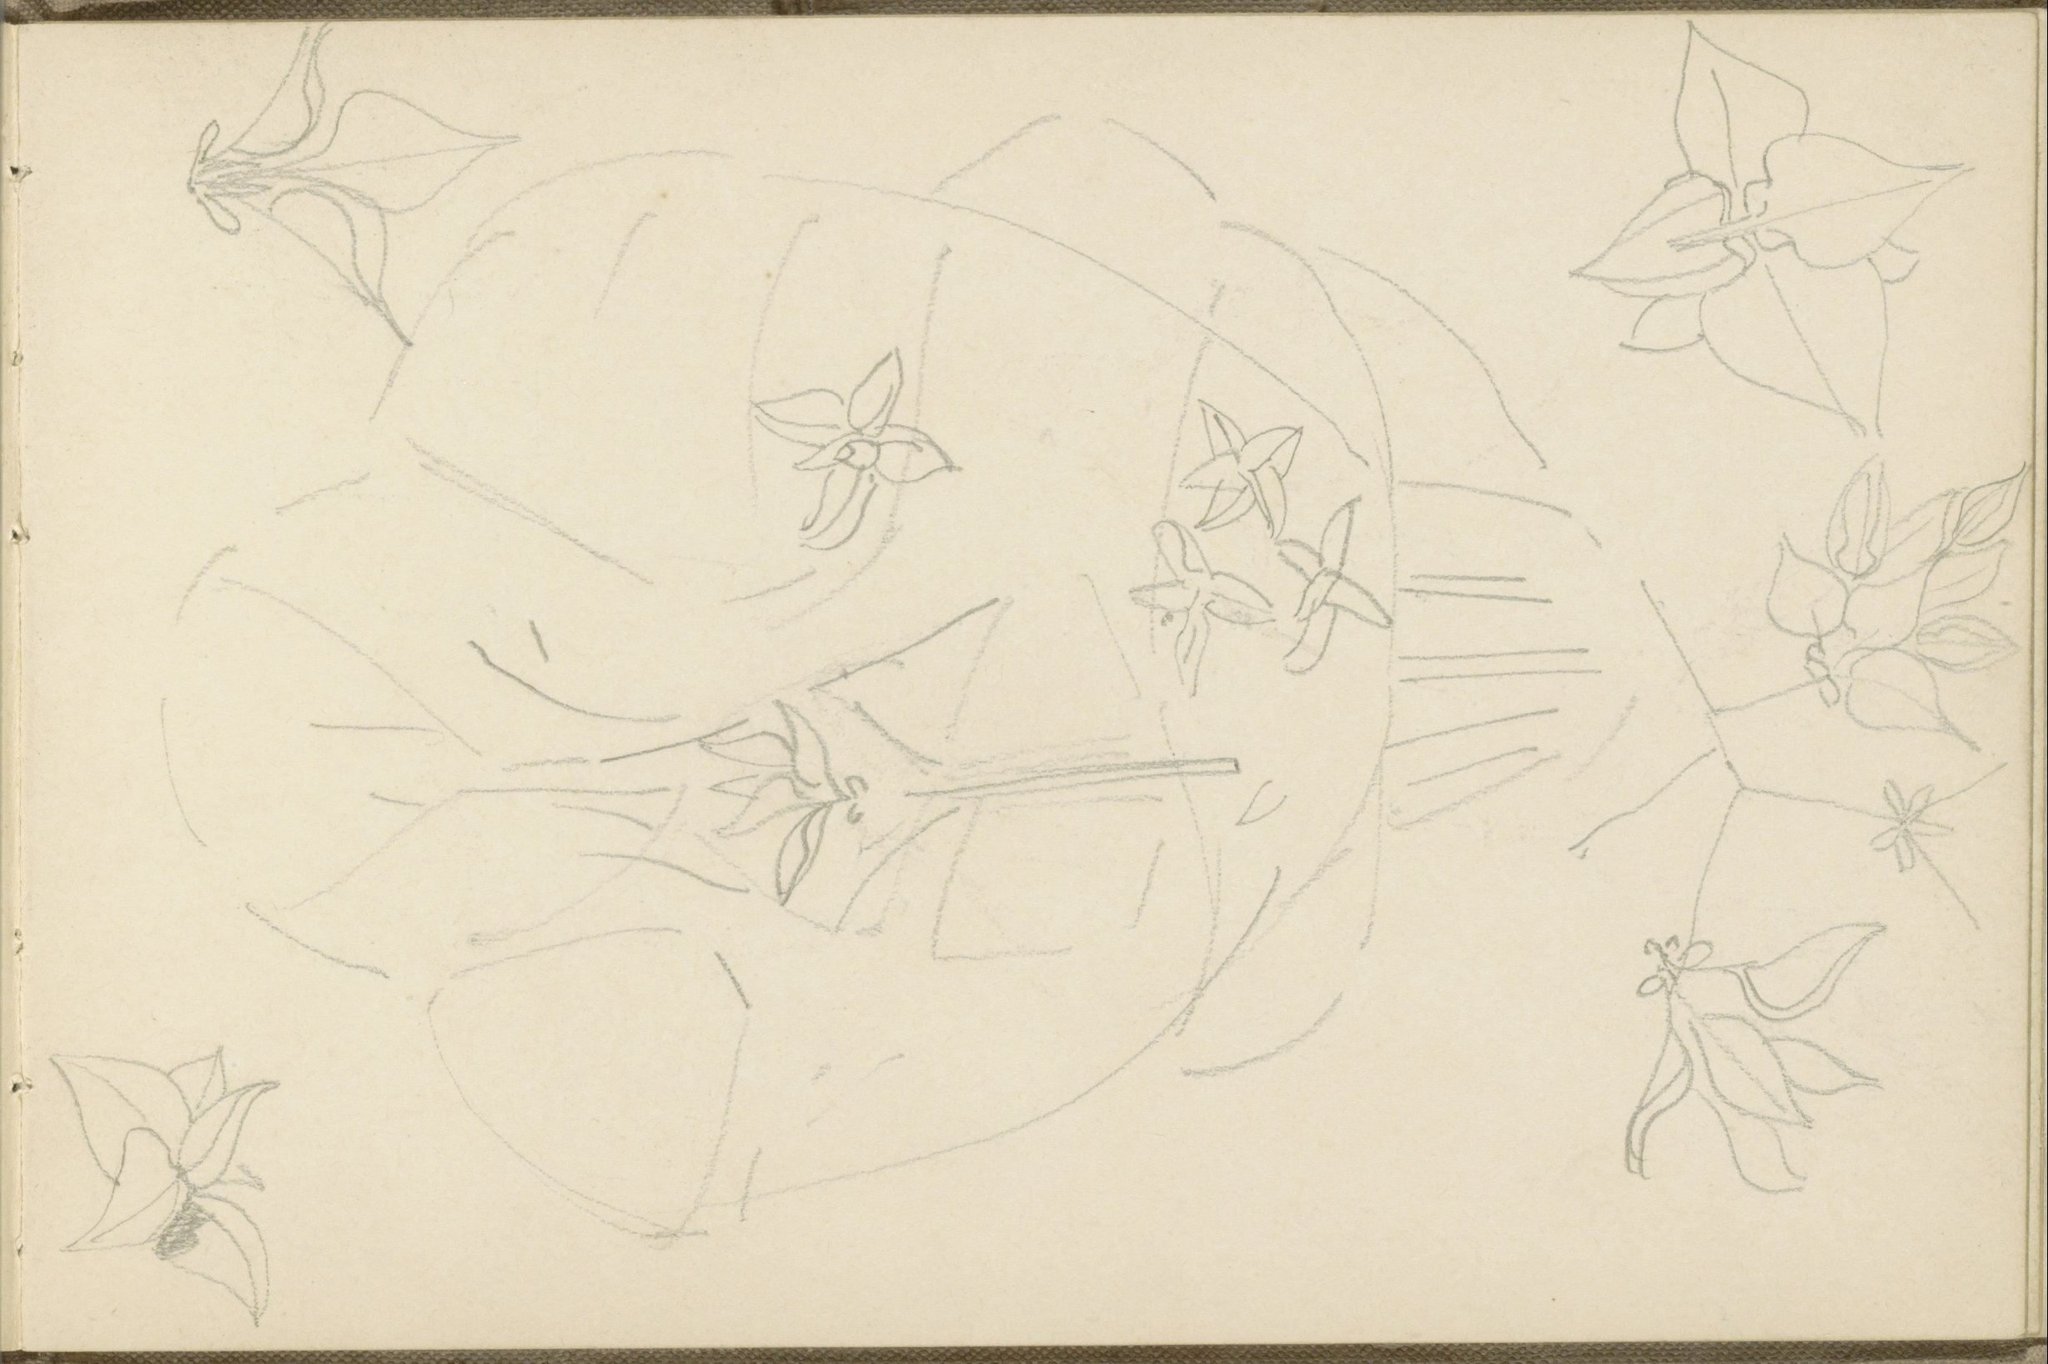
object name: sketchbook leaf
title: Bloemen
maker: carel adolph lion cachet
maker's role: draughtsman, print maker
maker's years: 1864-1945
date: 1905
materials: paper, pencil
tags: flowers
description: Blad 16 recto uit een schetsboek met 27 bladen.